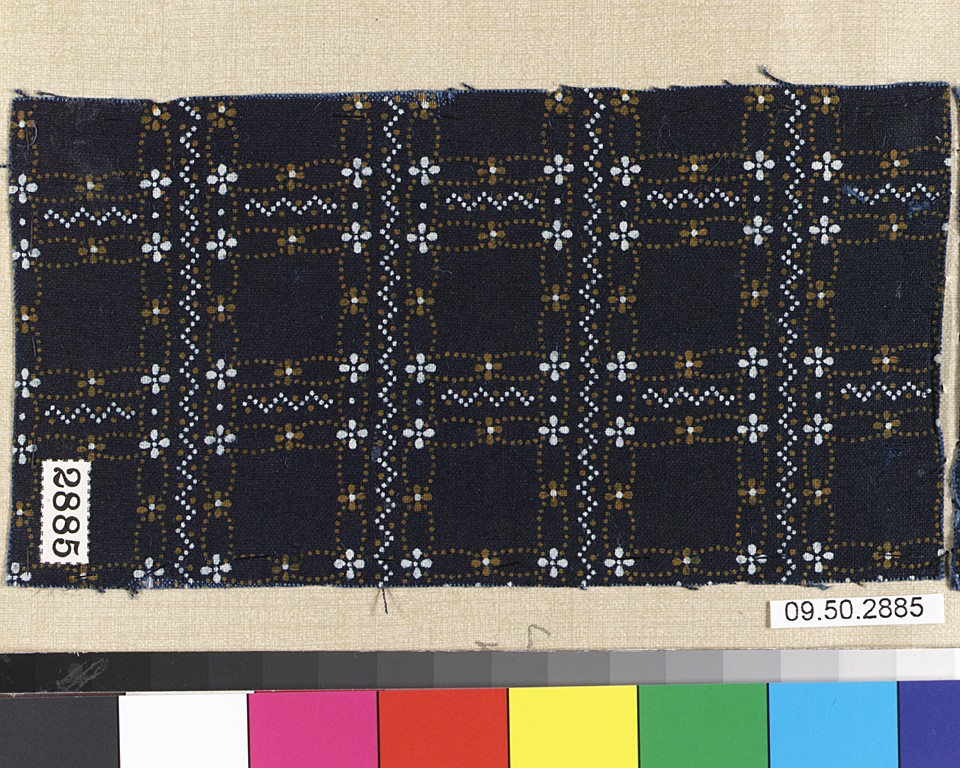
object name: piece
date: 1801-1900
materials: cotton